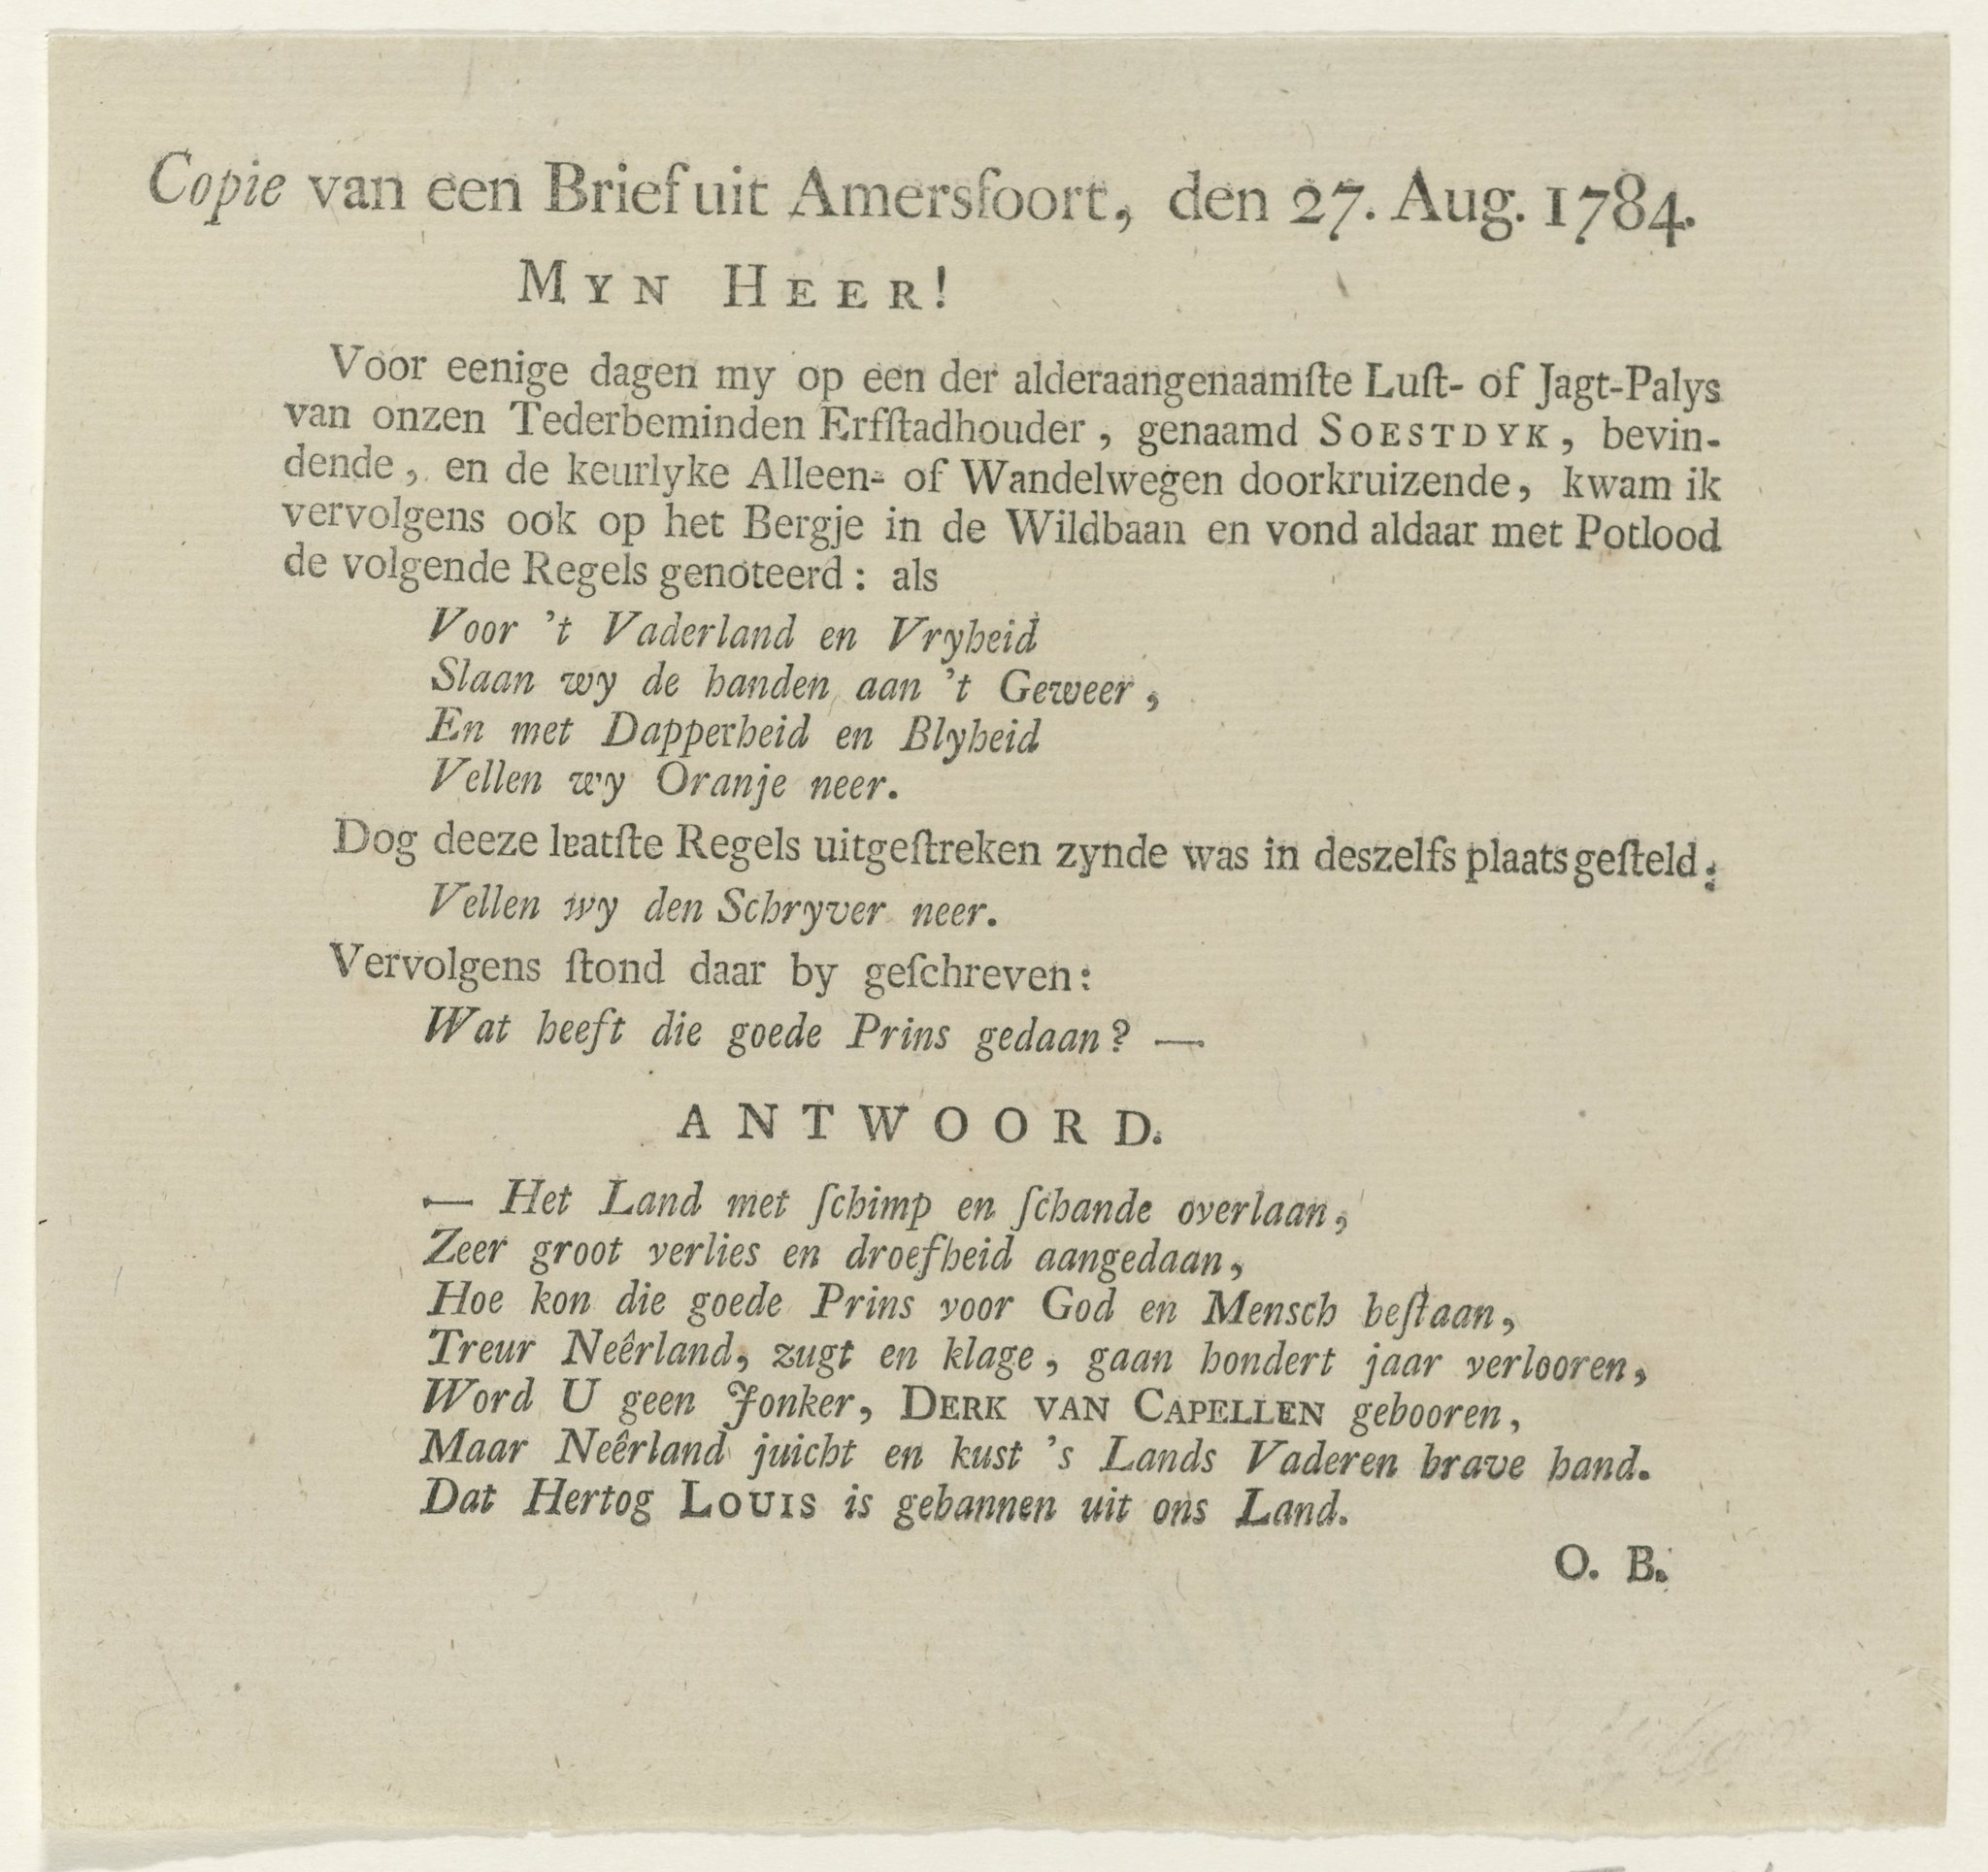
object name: text sheet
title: Copie van een Brief uit Amersfoort, den 27 Aug. 1784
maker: Anonymous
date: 1784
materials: paper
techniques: letterpress printing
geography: northern netherlands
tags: ludwig ernst von braunschweig-wolfenbüttel, patriots (1780-1795)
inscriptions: collector's mark: Lugt 2228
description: Spotvers op de hertog van Brunswijk, in de vorm van een brief dat in Amersfoort geschreven zou zijn. Naar aanleiding van zijn vertrek uit Nederland in 1784.